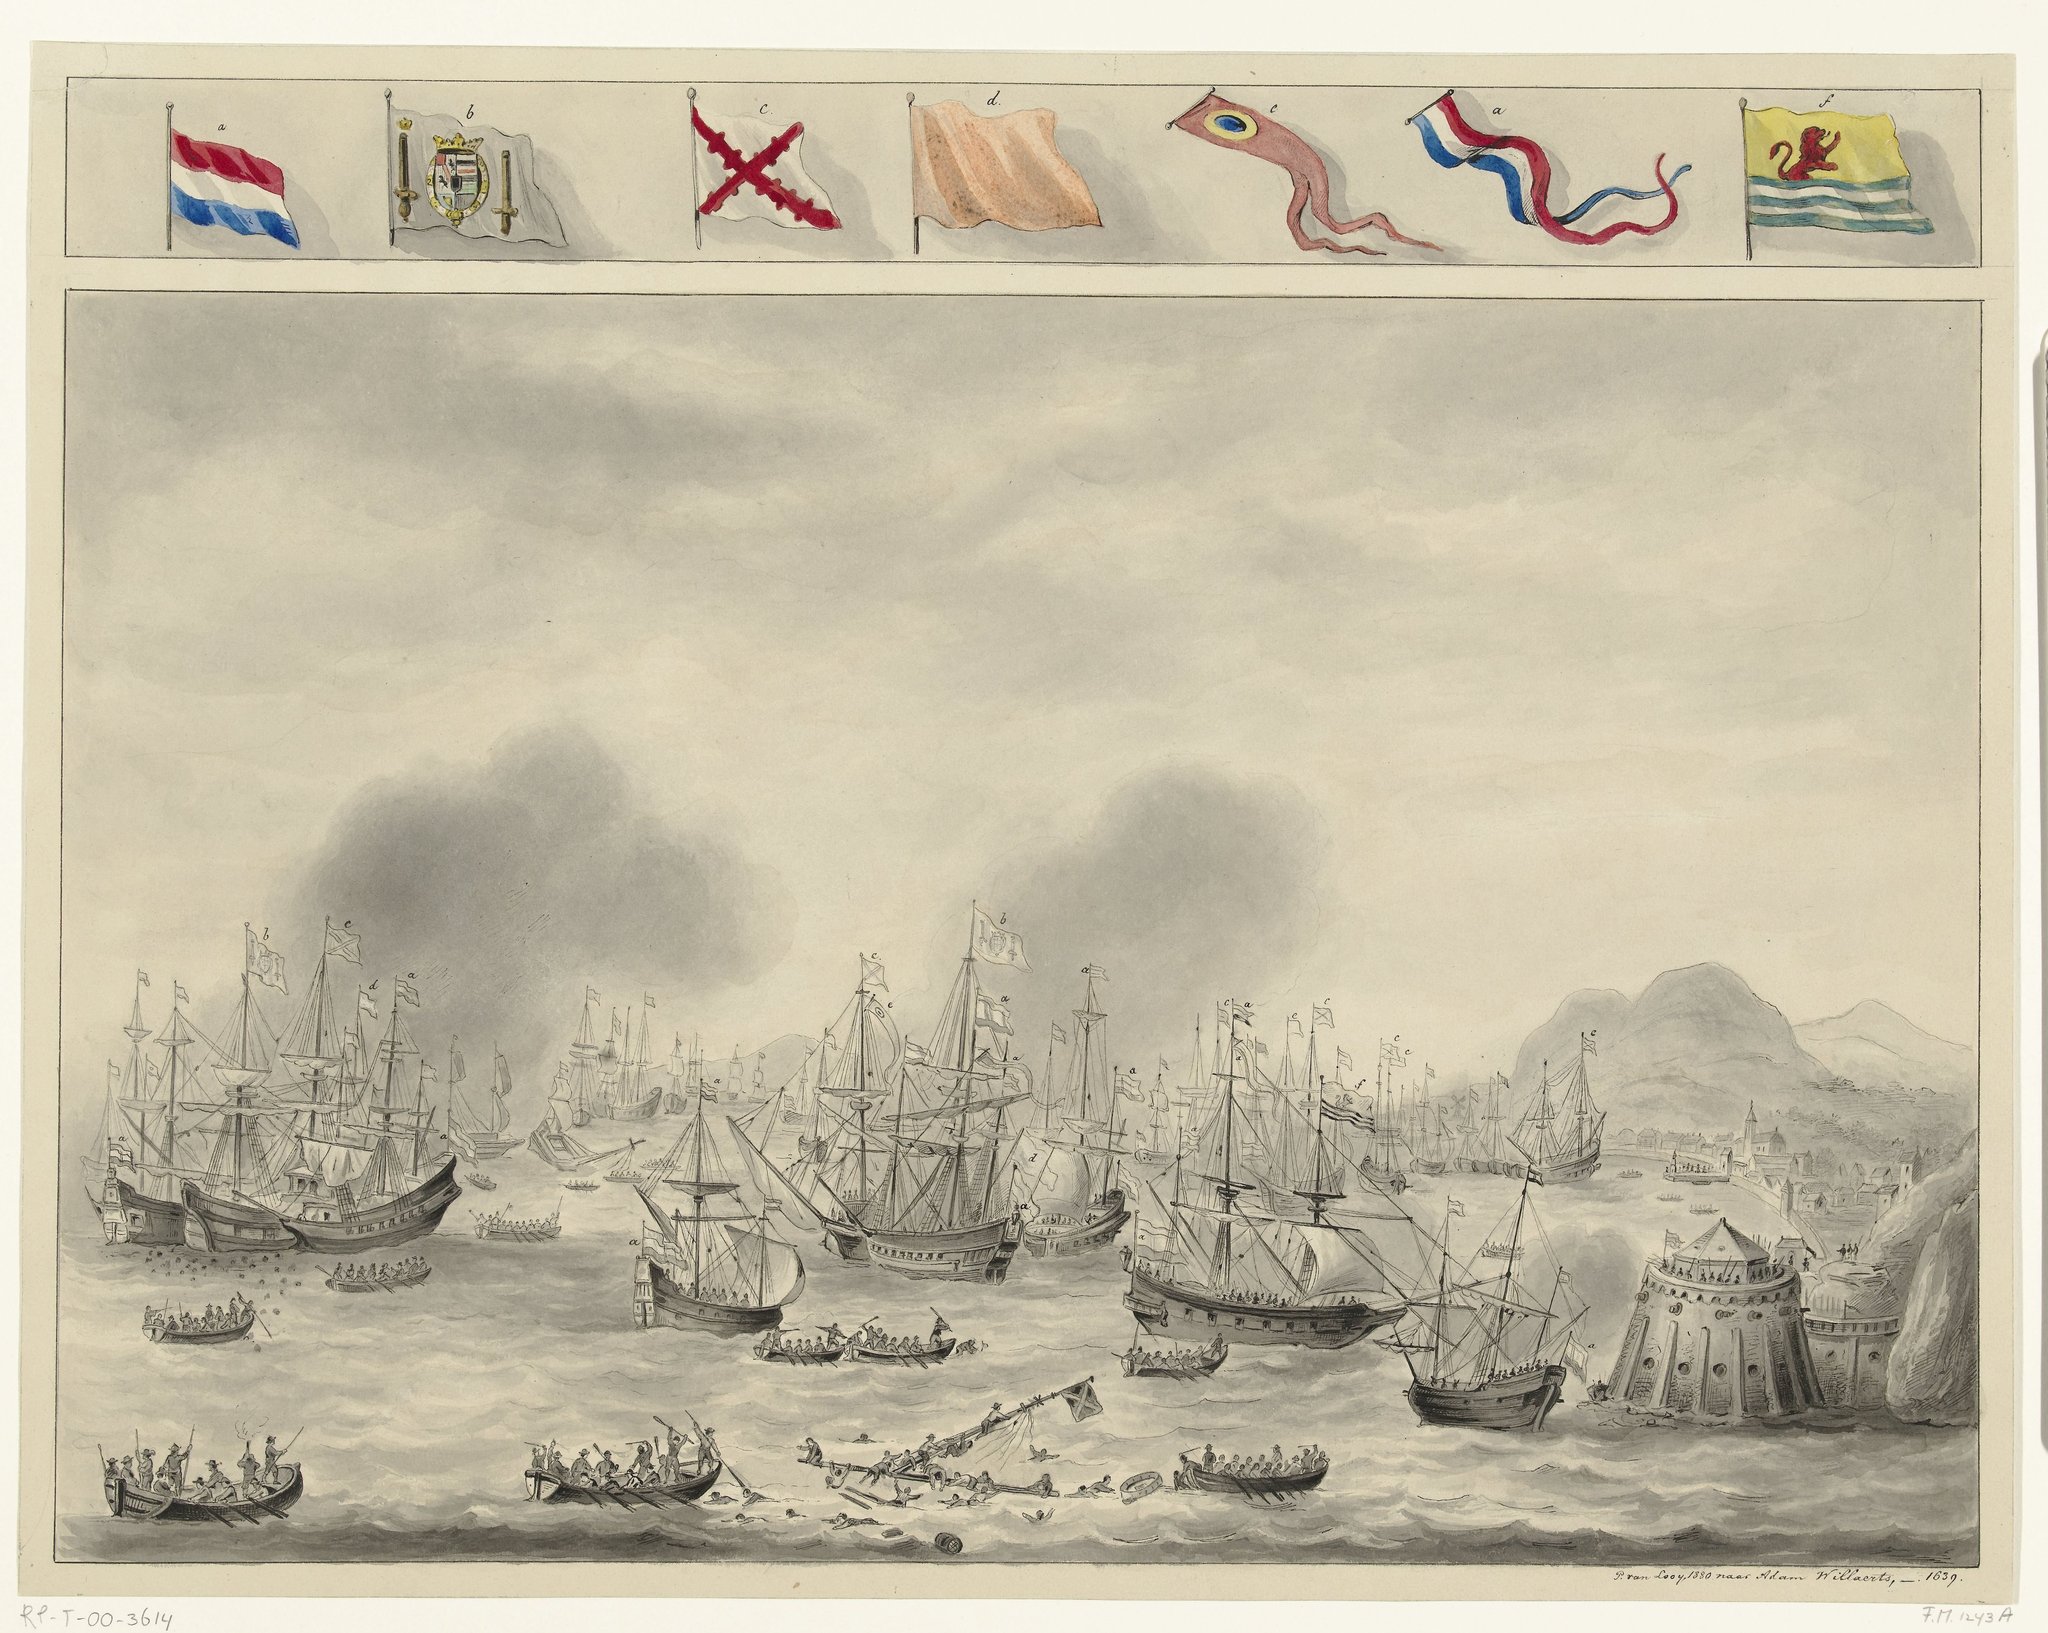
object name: drawing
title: Zeeslag voor Gibraltar, 25 april 1607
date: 1880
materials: ink, paper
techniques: brush, pen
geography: netherlands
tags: amsterdam, jacob van heemskerck, battle (+ naval force)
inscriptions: date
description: Zeeslag in de baai van Gibraltar op 25 april 1607 tussen de Staatse vloot onder admiraal Jacob van Heemskerck en de Spaanse vloot onder admiraal Don Juan Alvares de Avila. Rechts de stad en het kasteel van Gibraltar. Tekening gekopieerd naar het schilderij. Bovenaan zeven verschillende vlaggen en wimpels afgebeeld in kleur en genummerd a-f.